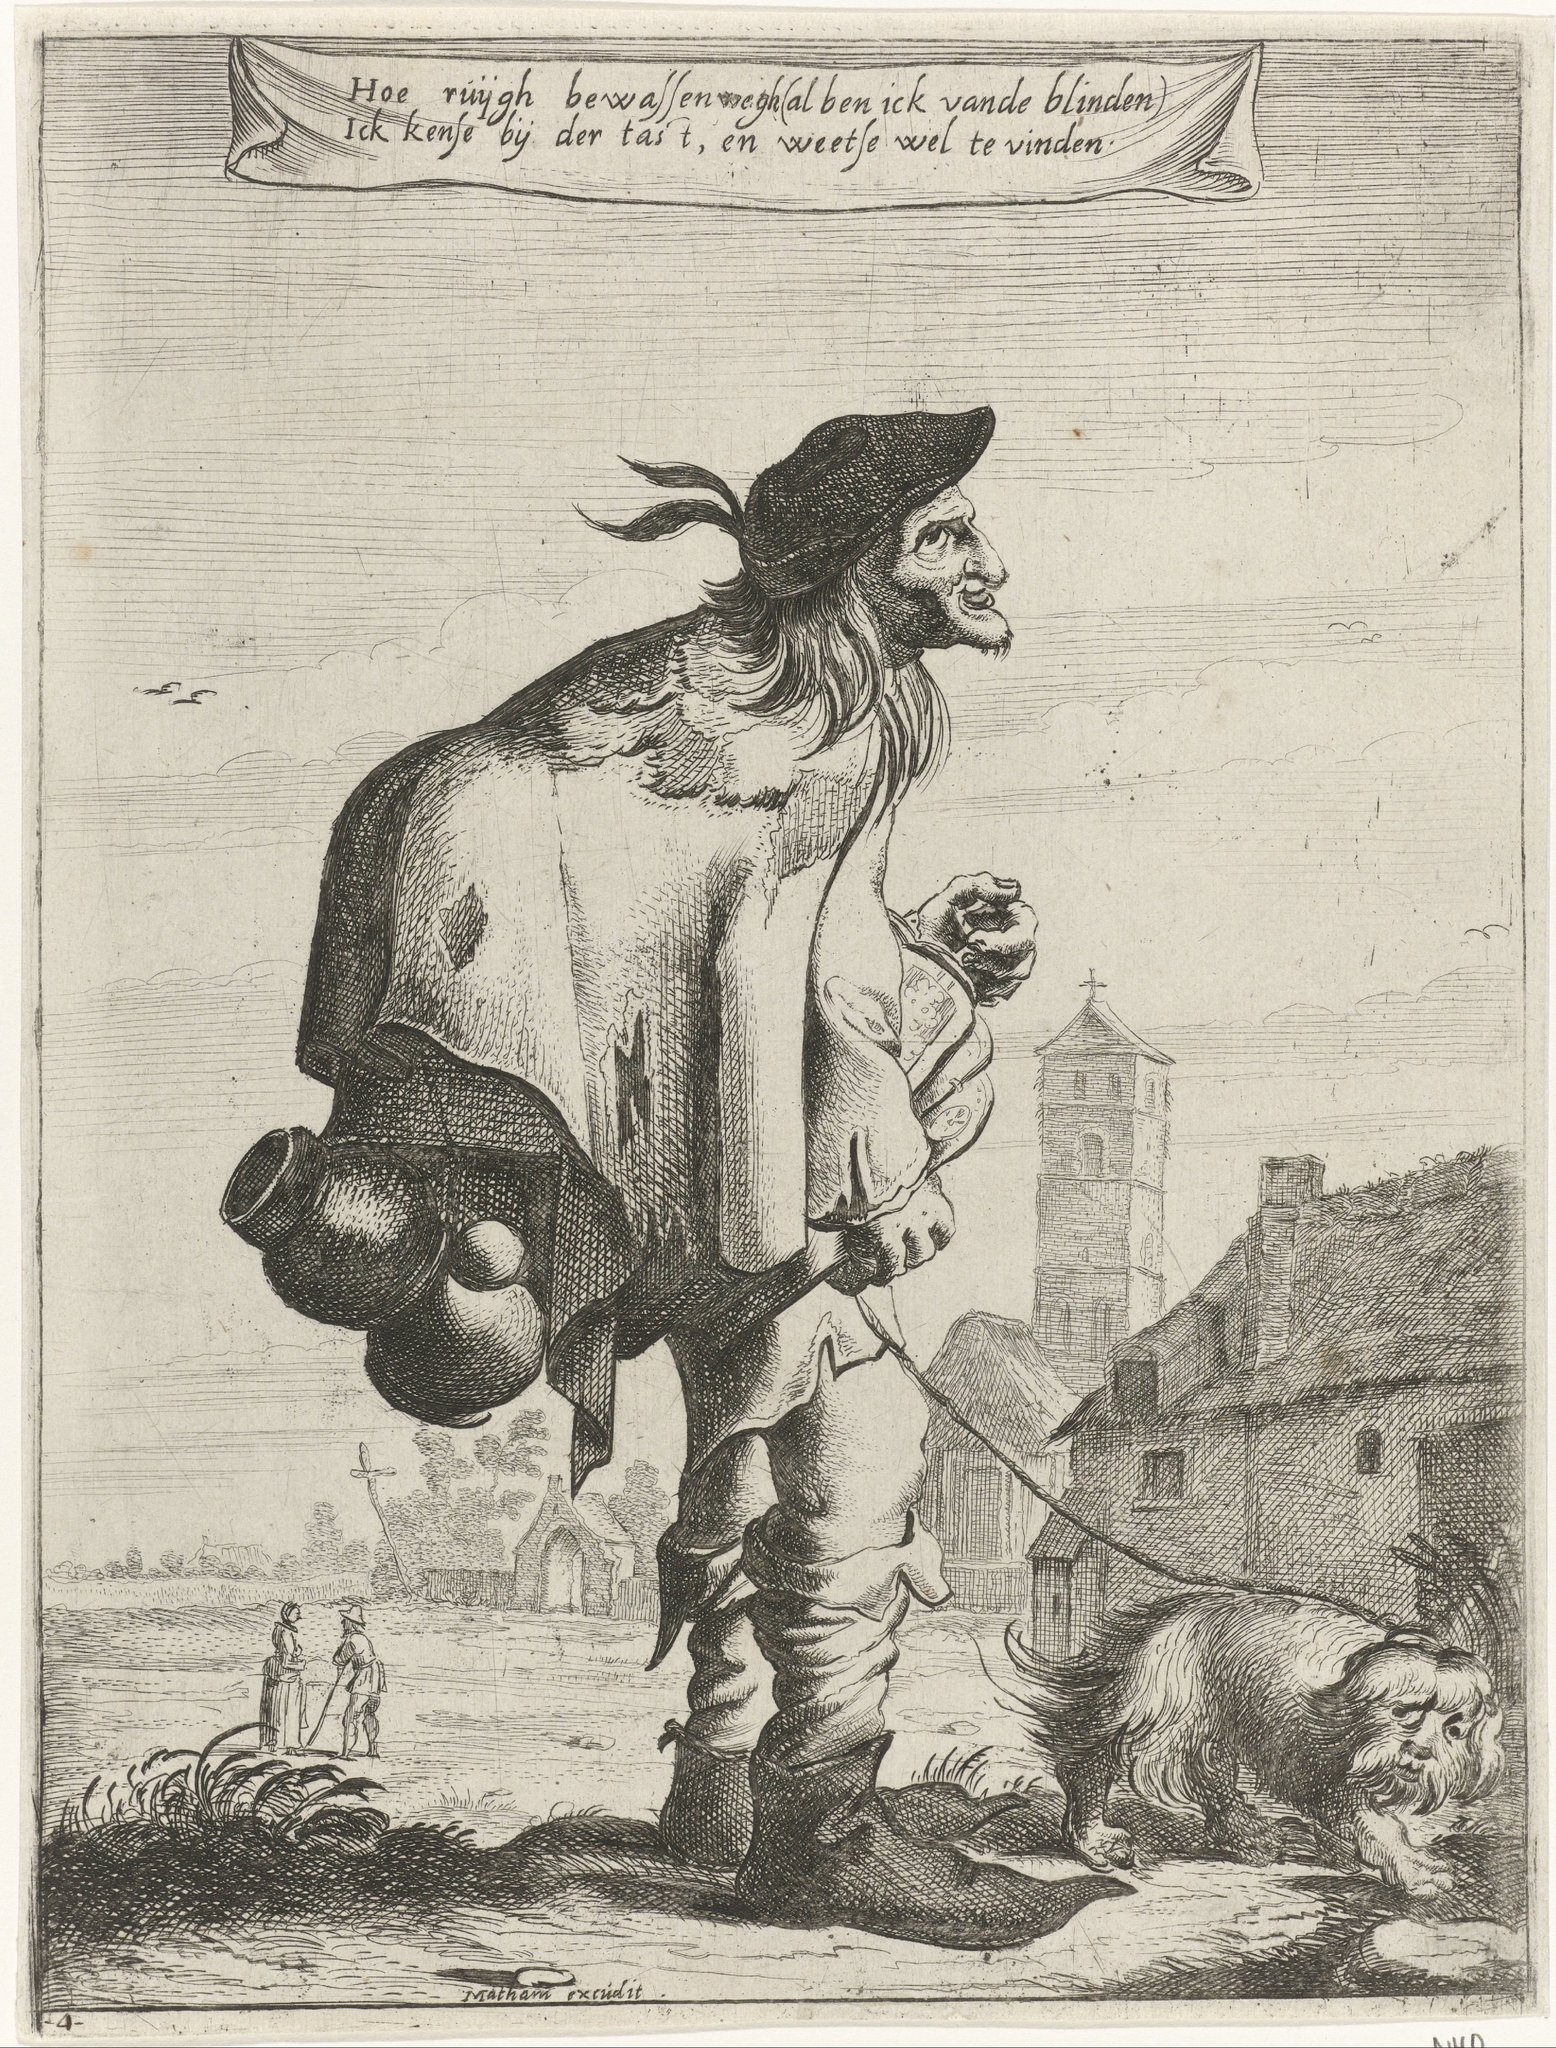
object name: print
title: Liereman met hond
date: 1628-1648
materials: paper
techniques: engraving, etching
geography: haarlem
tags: hurdy-gurdy - cc - out of doors, hurdy-gurdy player - cc - out of doors, dog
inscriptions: number: ‘4’, collector's mark: Lugt 2228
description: Een man met een draailier en potten op zijn rug, met een hond. Op de achtergrond een dorp en twee converserende figuren in een veld.